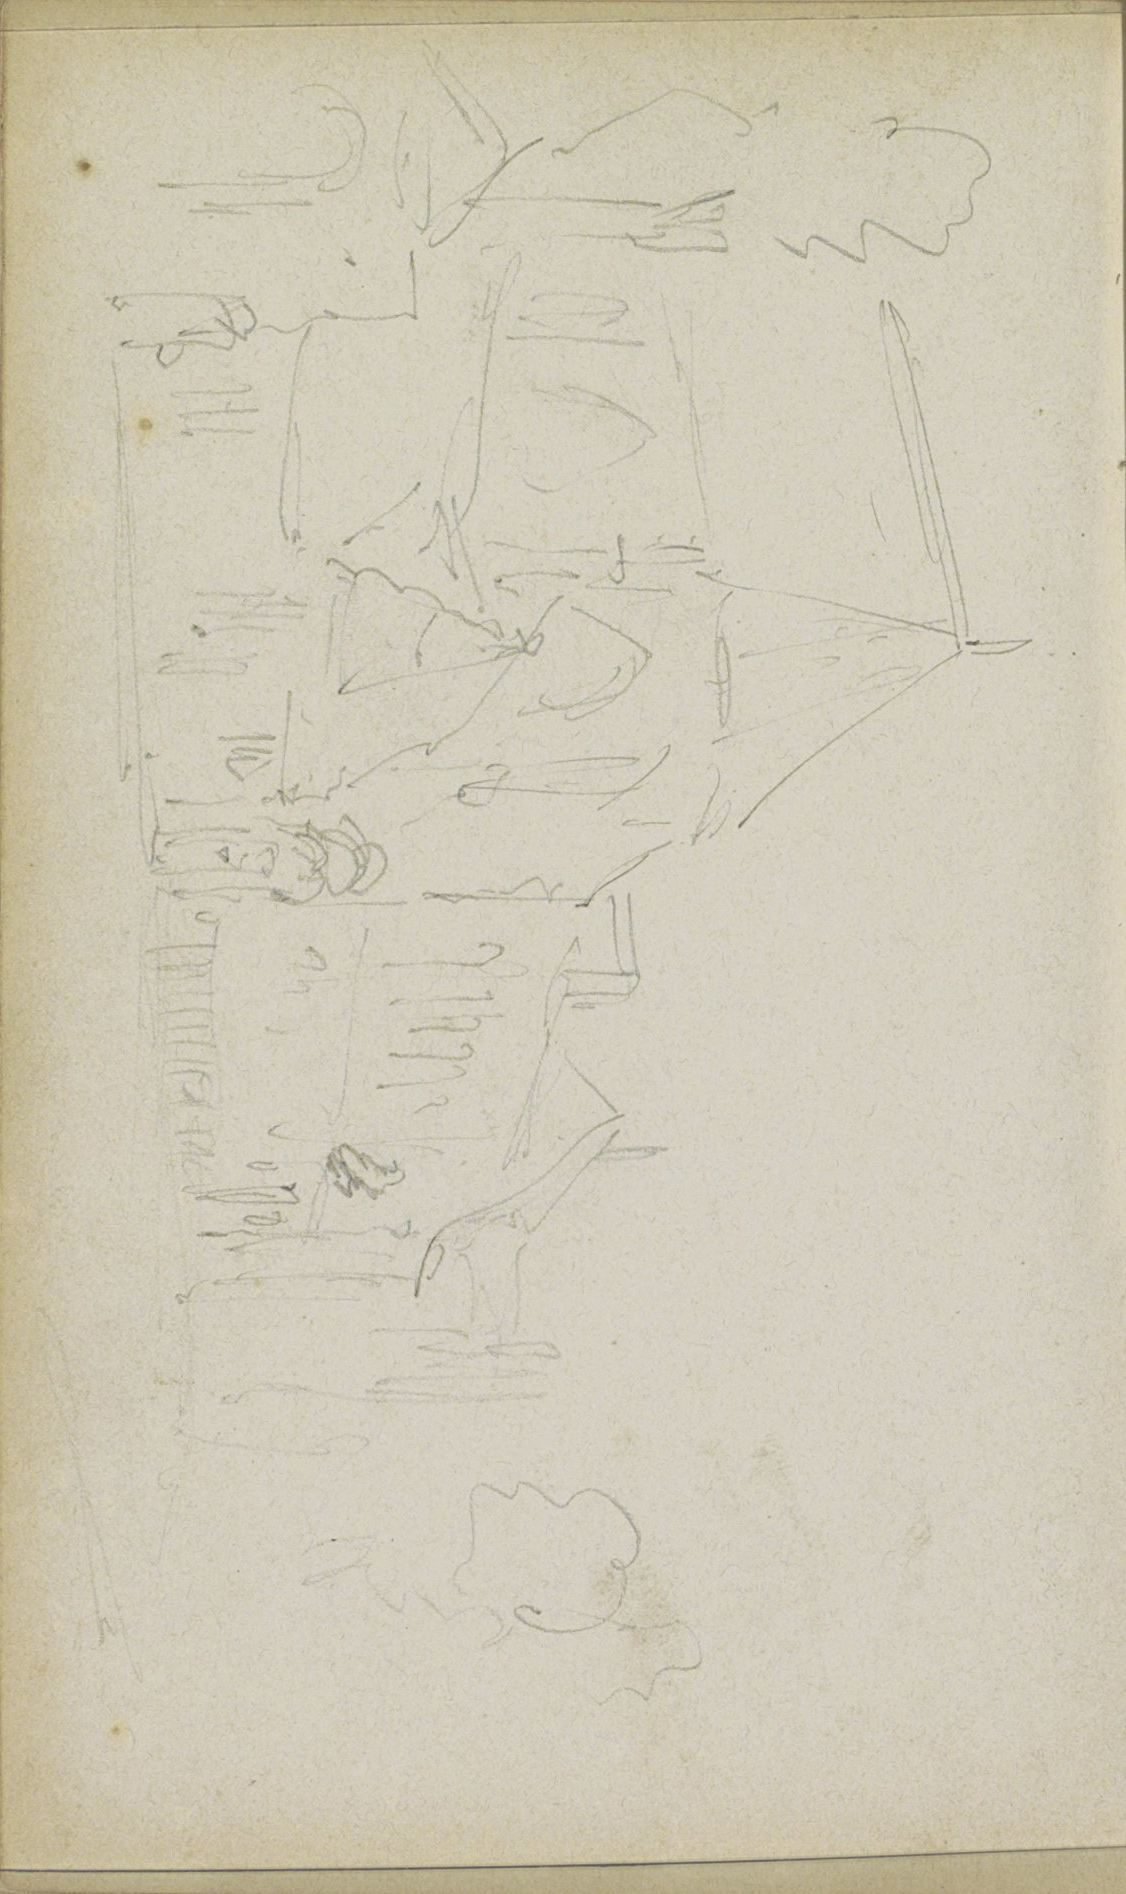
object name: sketchbook leaf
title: Gezicht op een straat met een kerk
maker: adrianus eversen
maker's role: draughtsman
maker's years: 1818-1897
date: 1828-1897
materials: paper, pencil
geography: netherlands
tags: urban housing, church (exterior), street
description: Gezicht op een straat met bomen. Tussen de huizen staat een kerk of kapel. Blad 28 verso uit een schetsboek met 69 bladen vervaardigd in de omgeving van Delft, Rotterdam, Oudewater en Harlingen.